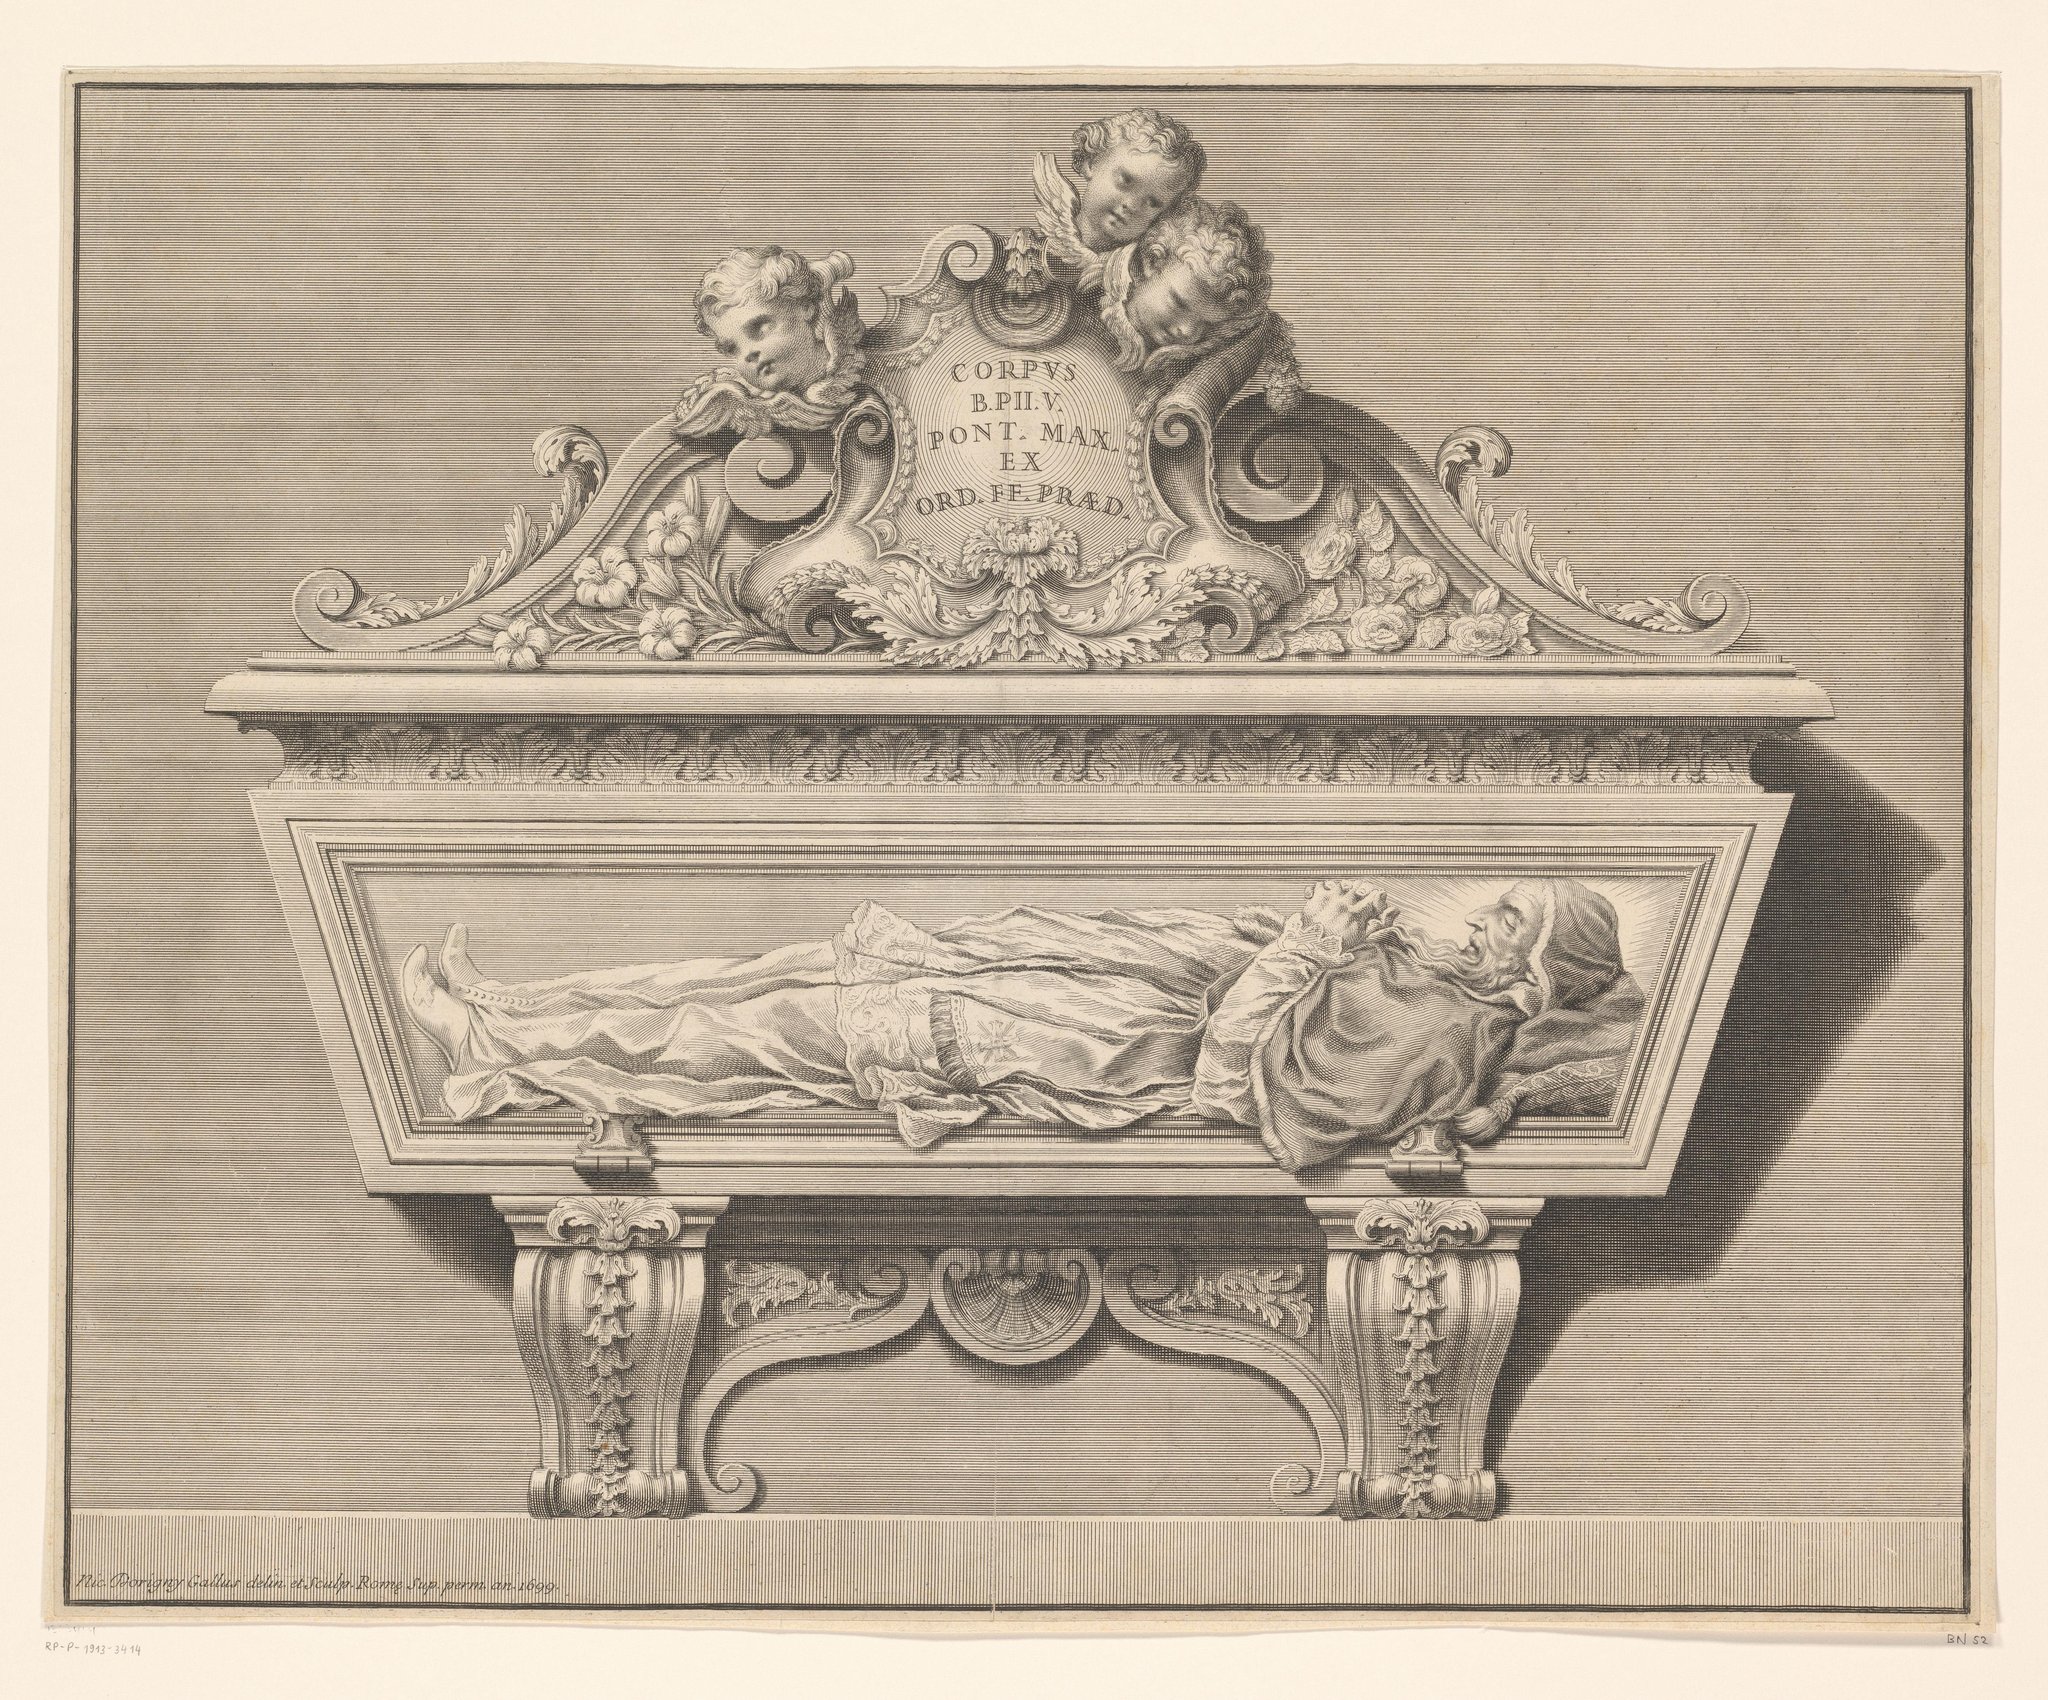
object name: print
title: Graftombe van Pius V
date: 1699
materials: paper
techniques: engraving, etching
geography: rome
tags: pius vi, historical persons, grave, tomb, pope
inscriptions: collector's mark: Lugt 2228